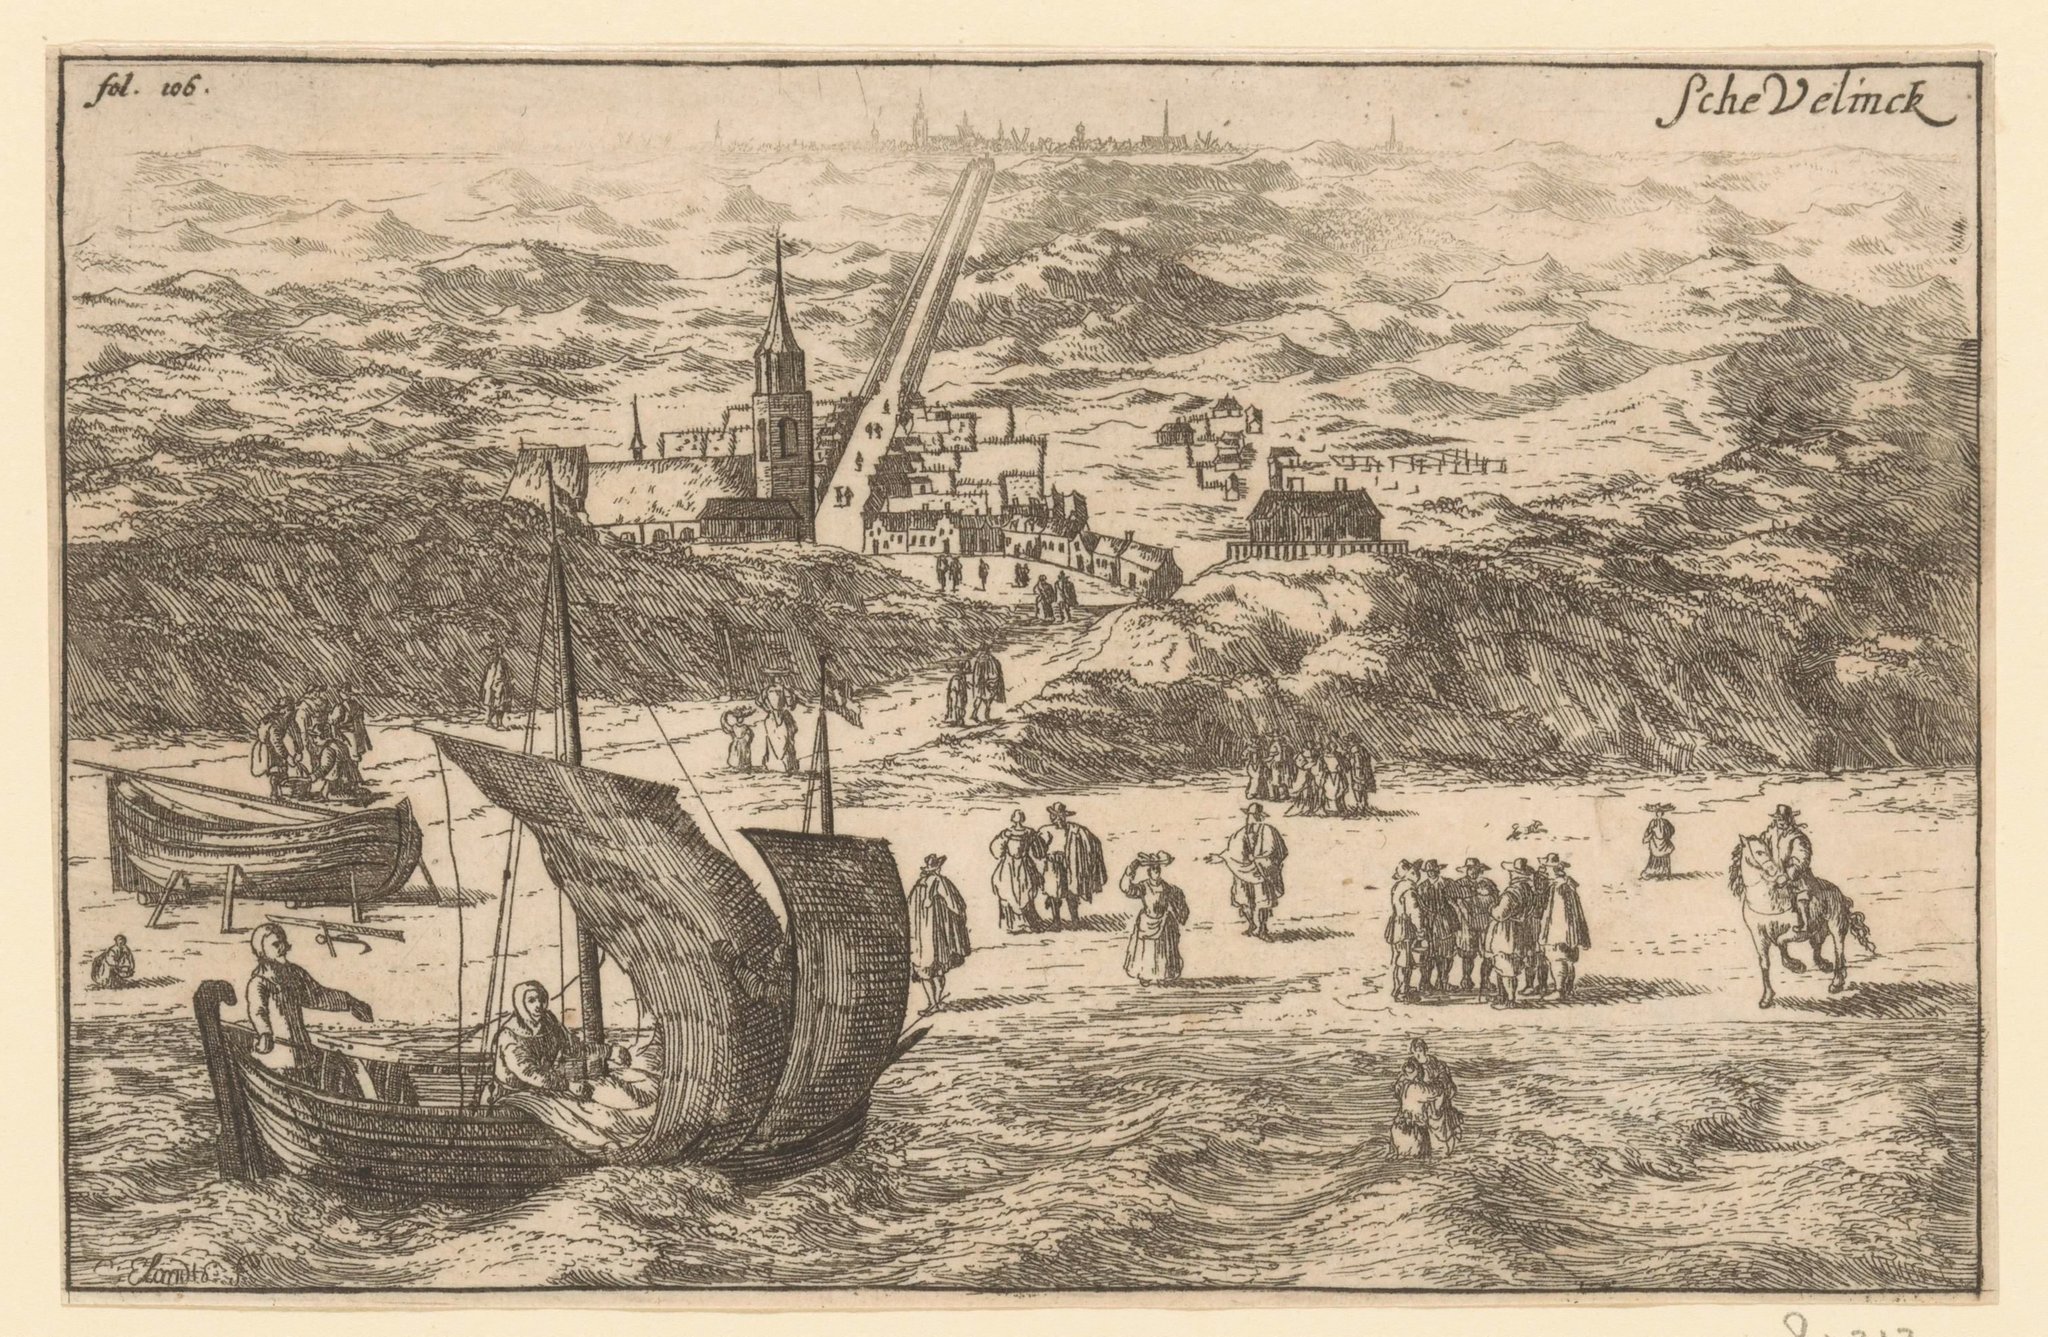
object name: print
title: Gezicht op Scheveningen vanaf zee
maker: cornelis elandts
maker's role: draughtsman, painter, print maker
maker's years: 1641-1687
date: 1668-1700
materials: paper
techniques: etching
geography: the hague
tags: prospect of village, silhouette of village, sailing-ship, sailing-boat, church (exterior), prospect of city, town panorama, silhouette of city, beach (+ landscape with figures, staffage), sea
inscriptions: collector's mark: Lugt 2228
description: Prent ook gebruikt in: Does, Jacob van der. 's Graven-Hage, met de voornaemste plaetsen en vermaecklijckheden. Den Haag: Hermanus Gael, 1668, tussen p. 106 en 107. Of in: Does, Jacob van der. 's Graven-Hage, met de voornaemste plaetsen en vermaecklijckheden. Den Haag: Johannes Tongerloo, 1668, tussen p. 106 en 107. Of in: Does, Jacob van der. 's Graven-Hage, met de voornaemste plaetsen en vermaeklykheden. Den Haag: Abraham Troyel, 1700. Zie ook RP-P-1909-1597 en RP-P-AO-11-44-2.